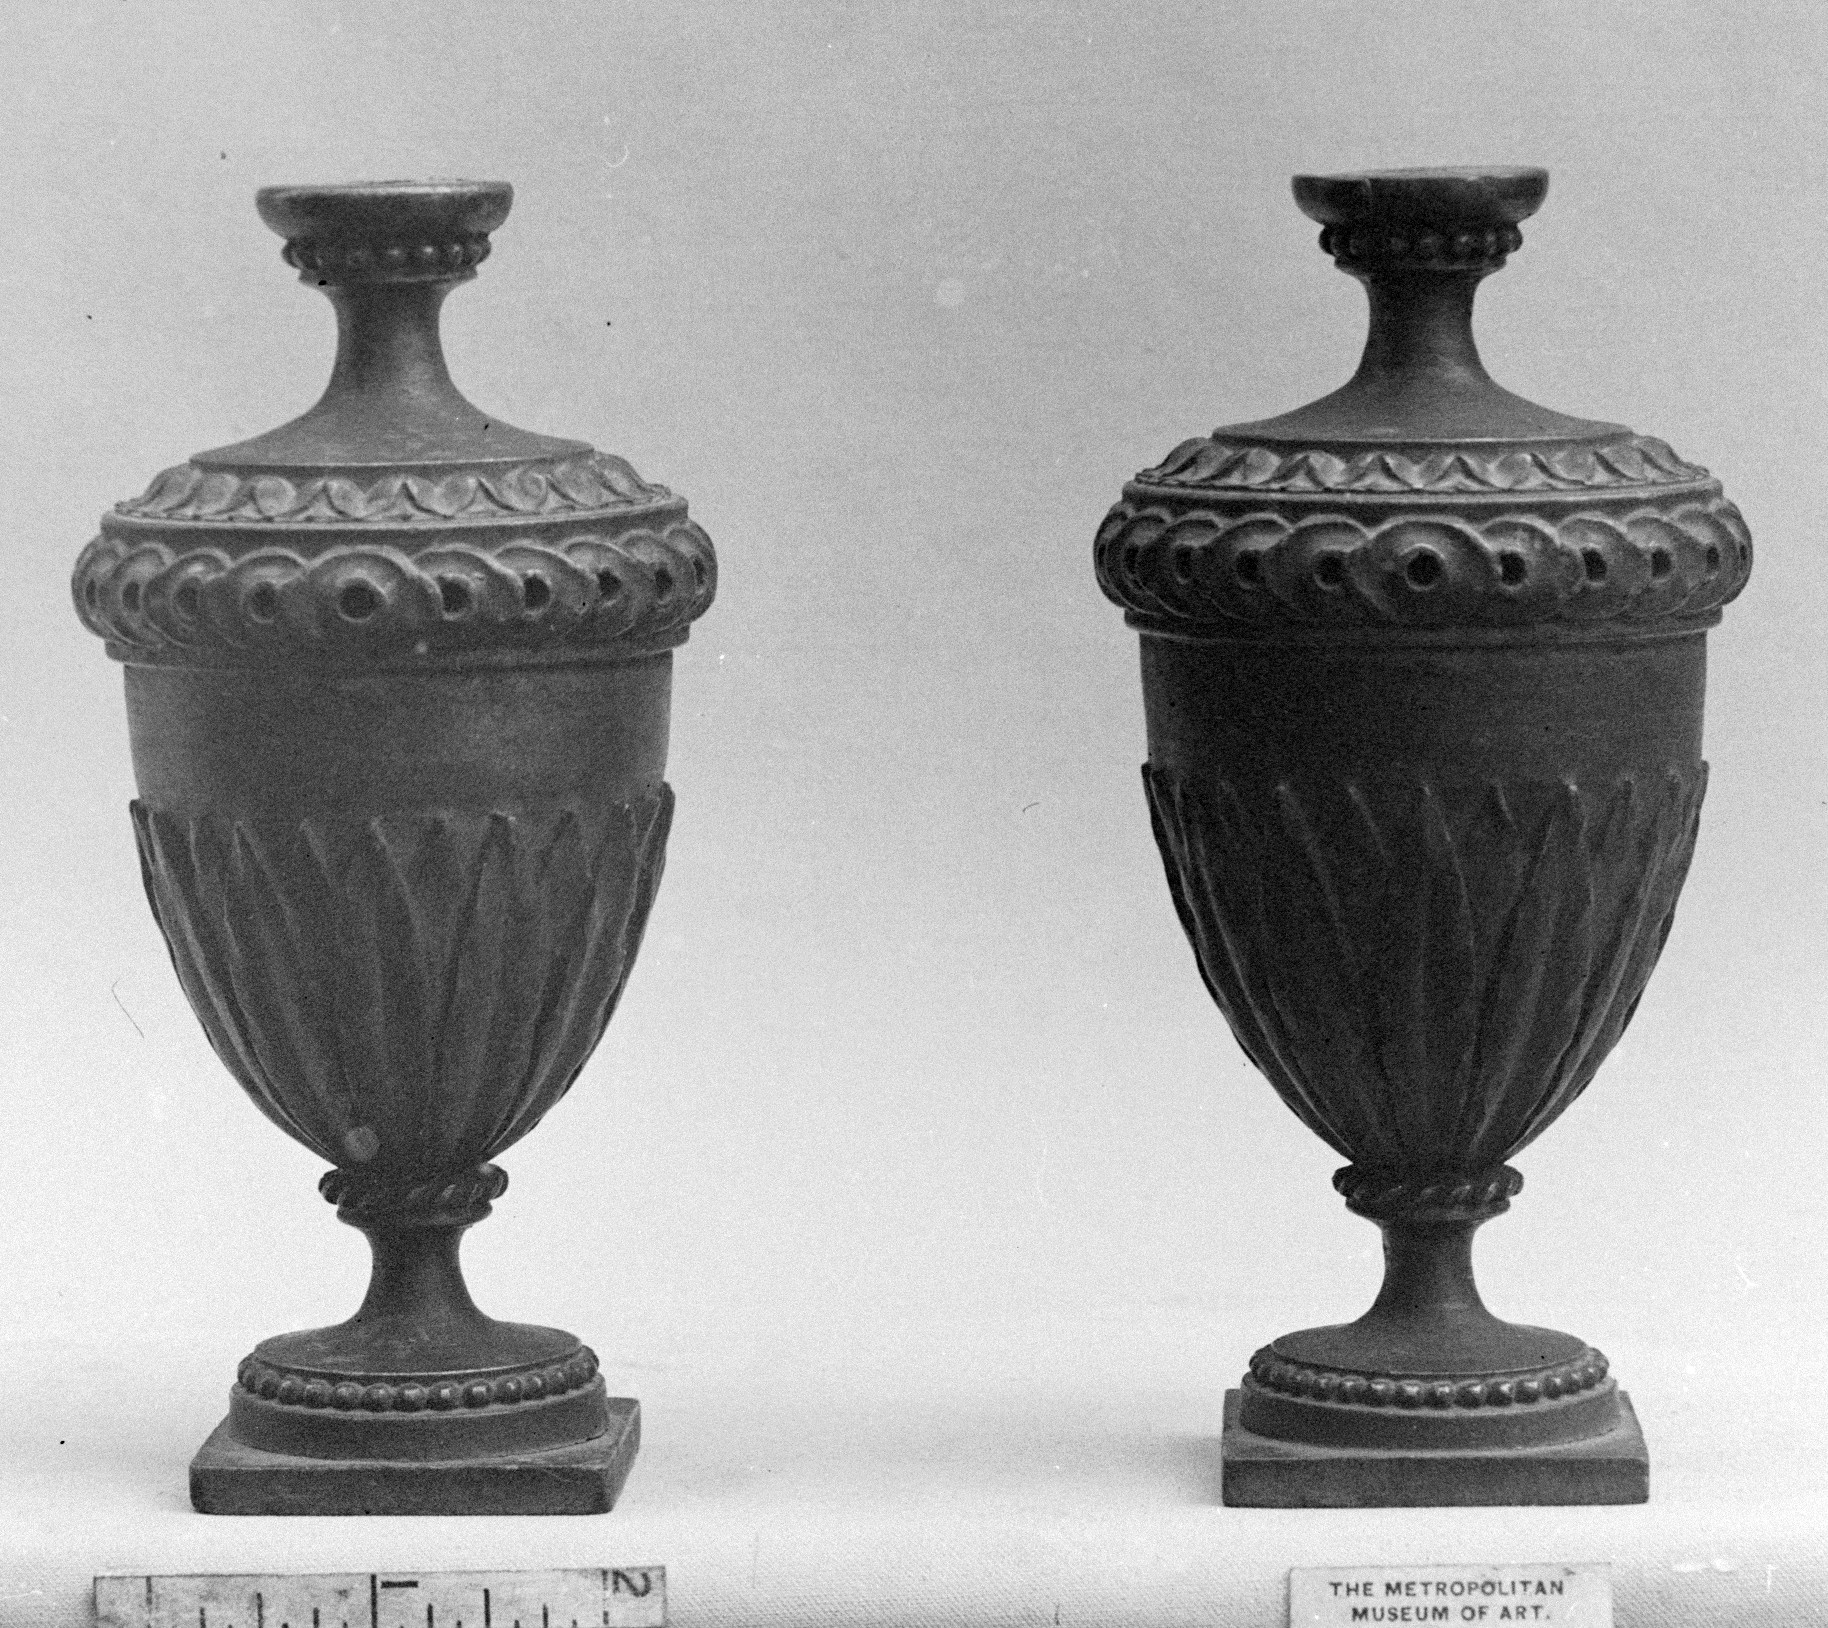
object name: vase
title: Pair of vases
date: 1701-1800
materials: gilt, wood